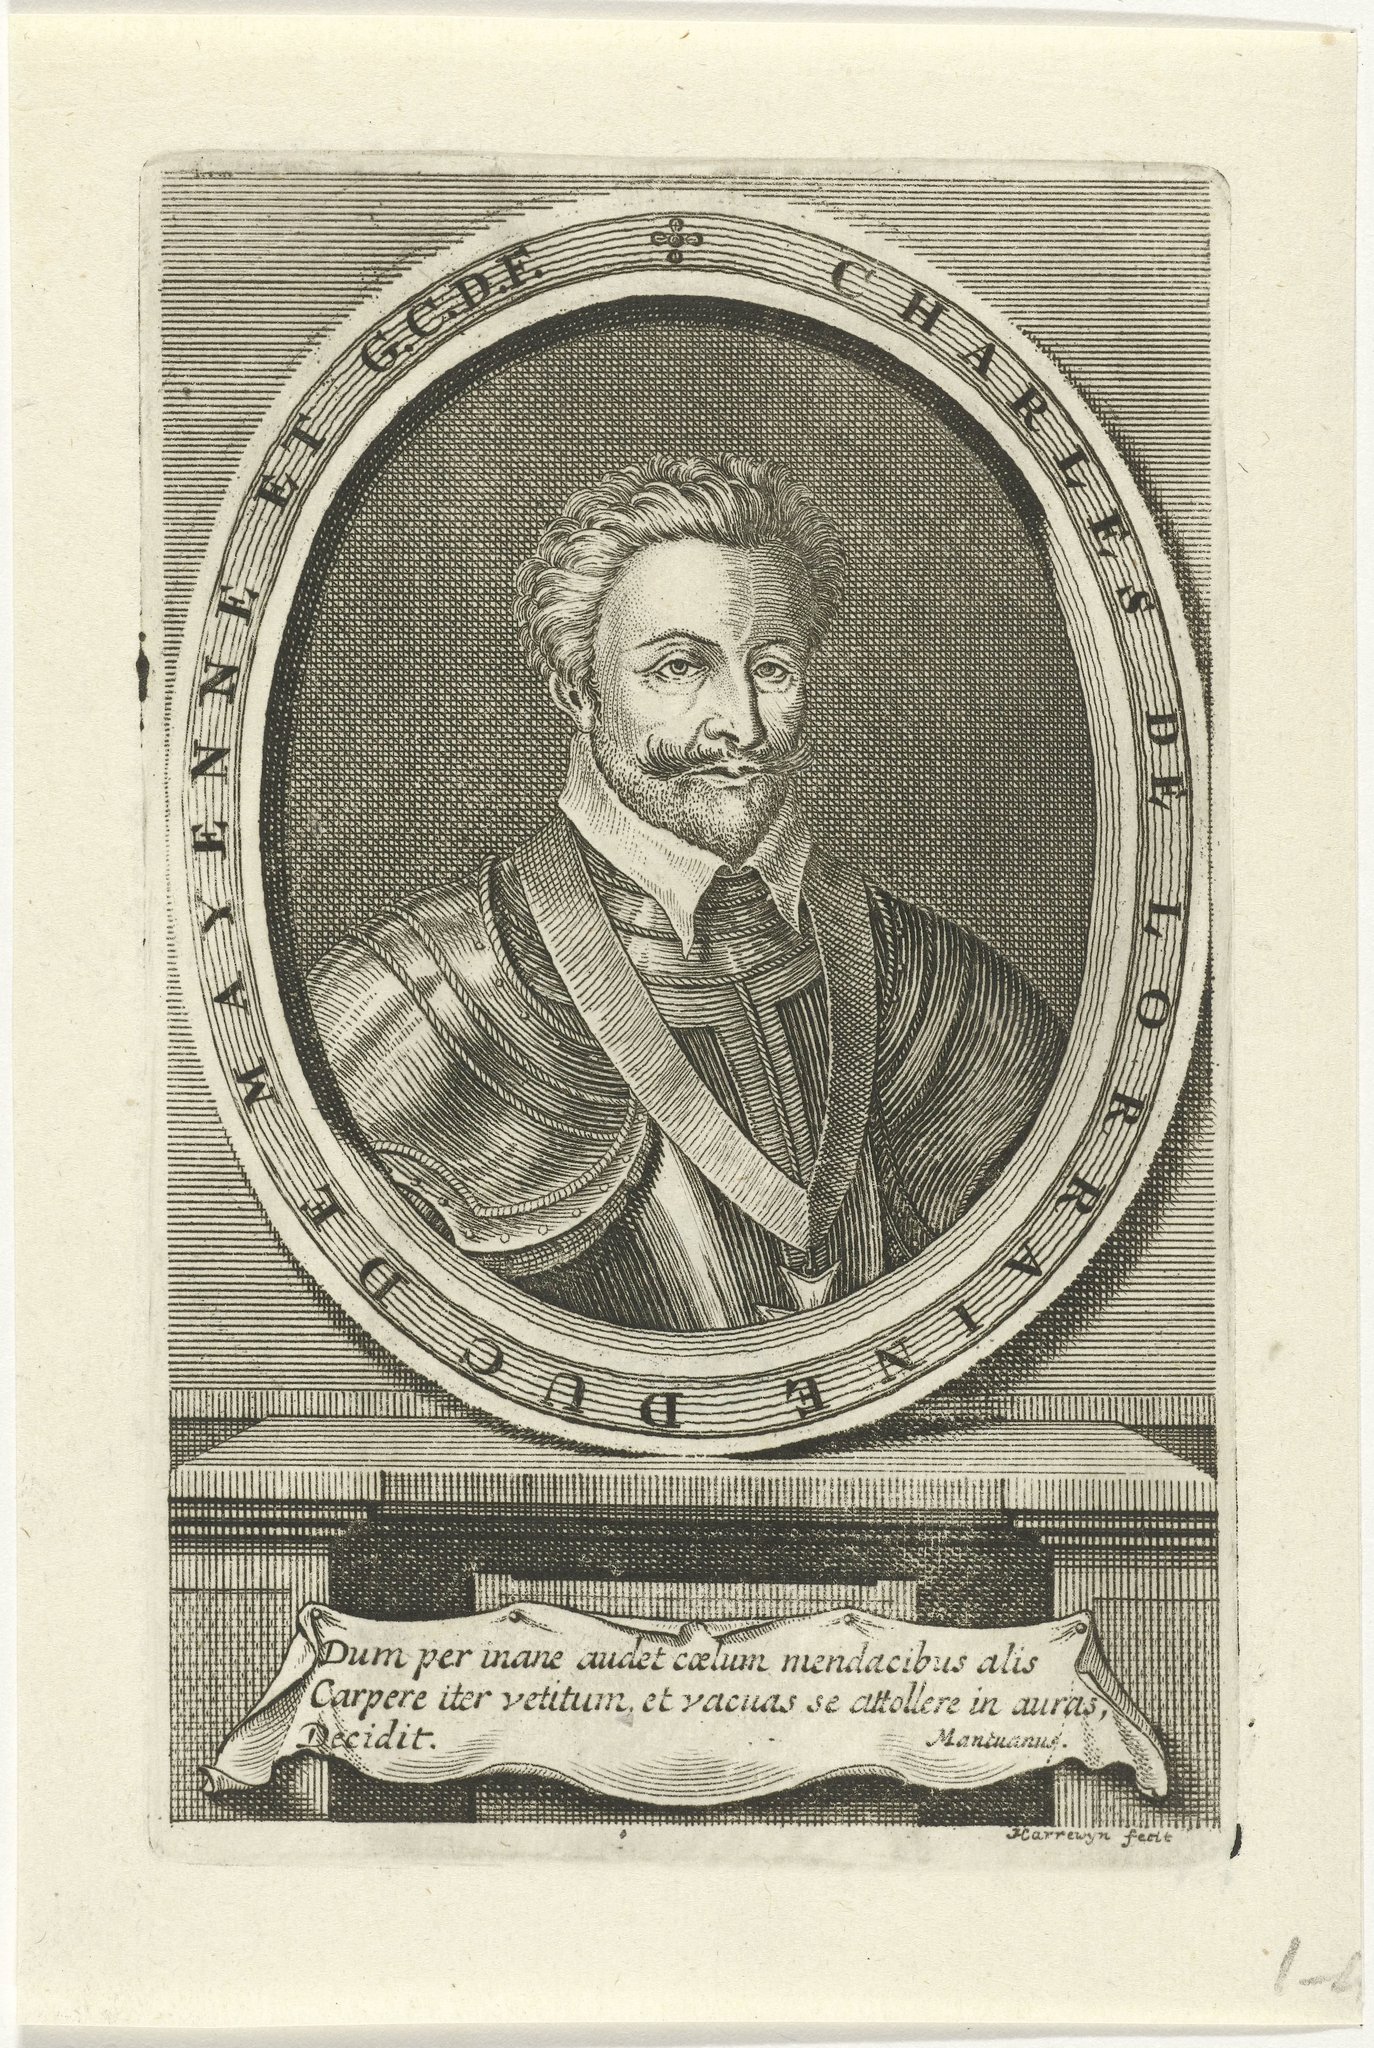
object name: print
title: Portret van Charles de Guise, duc de Mayenne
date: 1682-1730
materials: paper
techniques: engraving, etching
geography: low countries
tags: armour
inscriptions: collector's mark: Lugt 2228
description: Buste naar rechts van Charles de Guise, hertog van Mayenne in een ovaal met daarin zijn naam en titel. Onder het portret een drieregelige tekst in het Latijn.